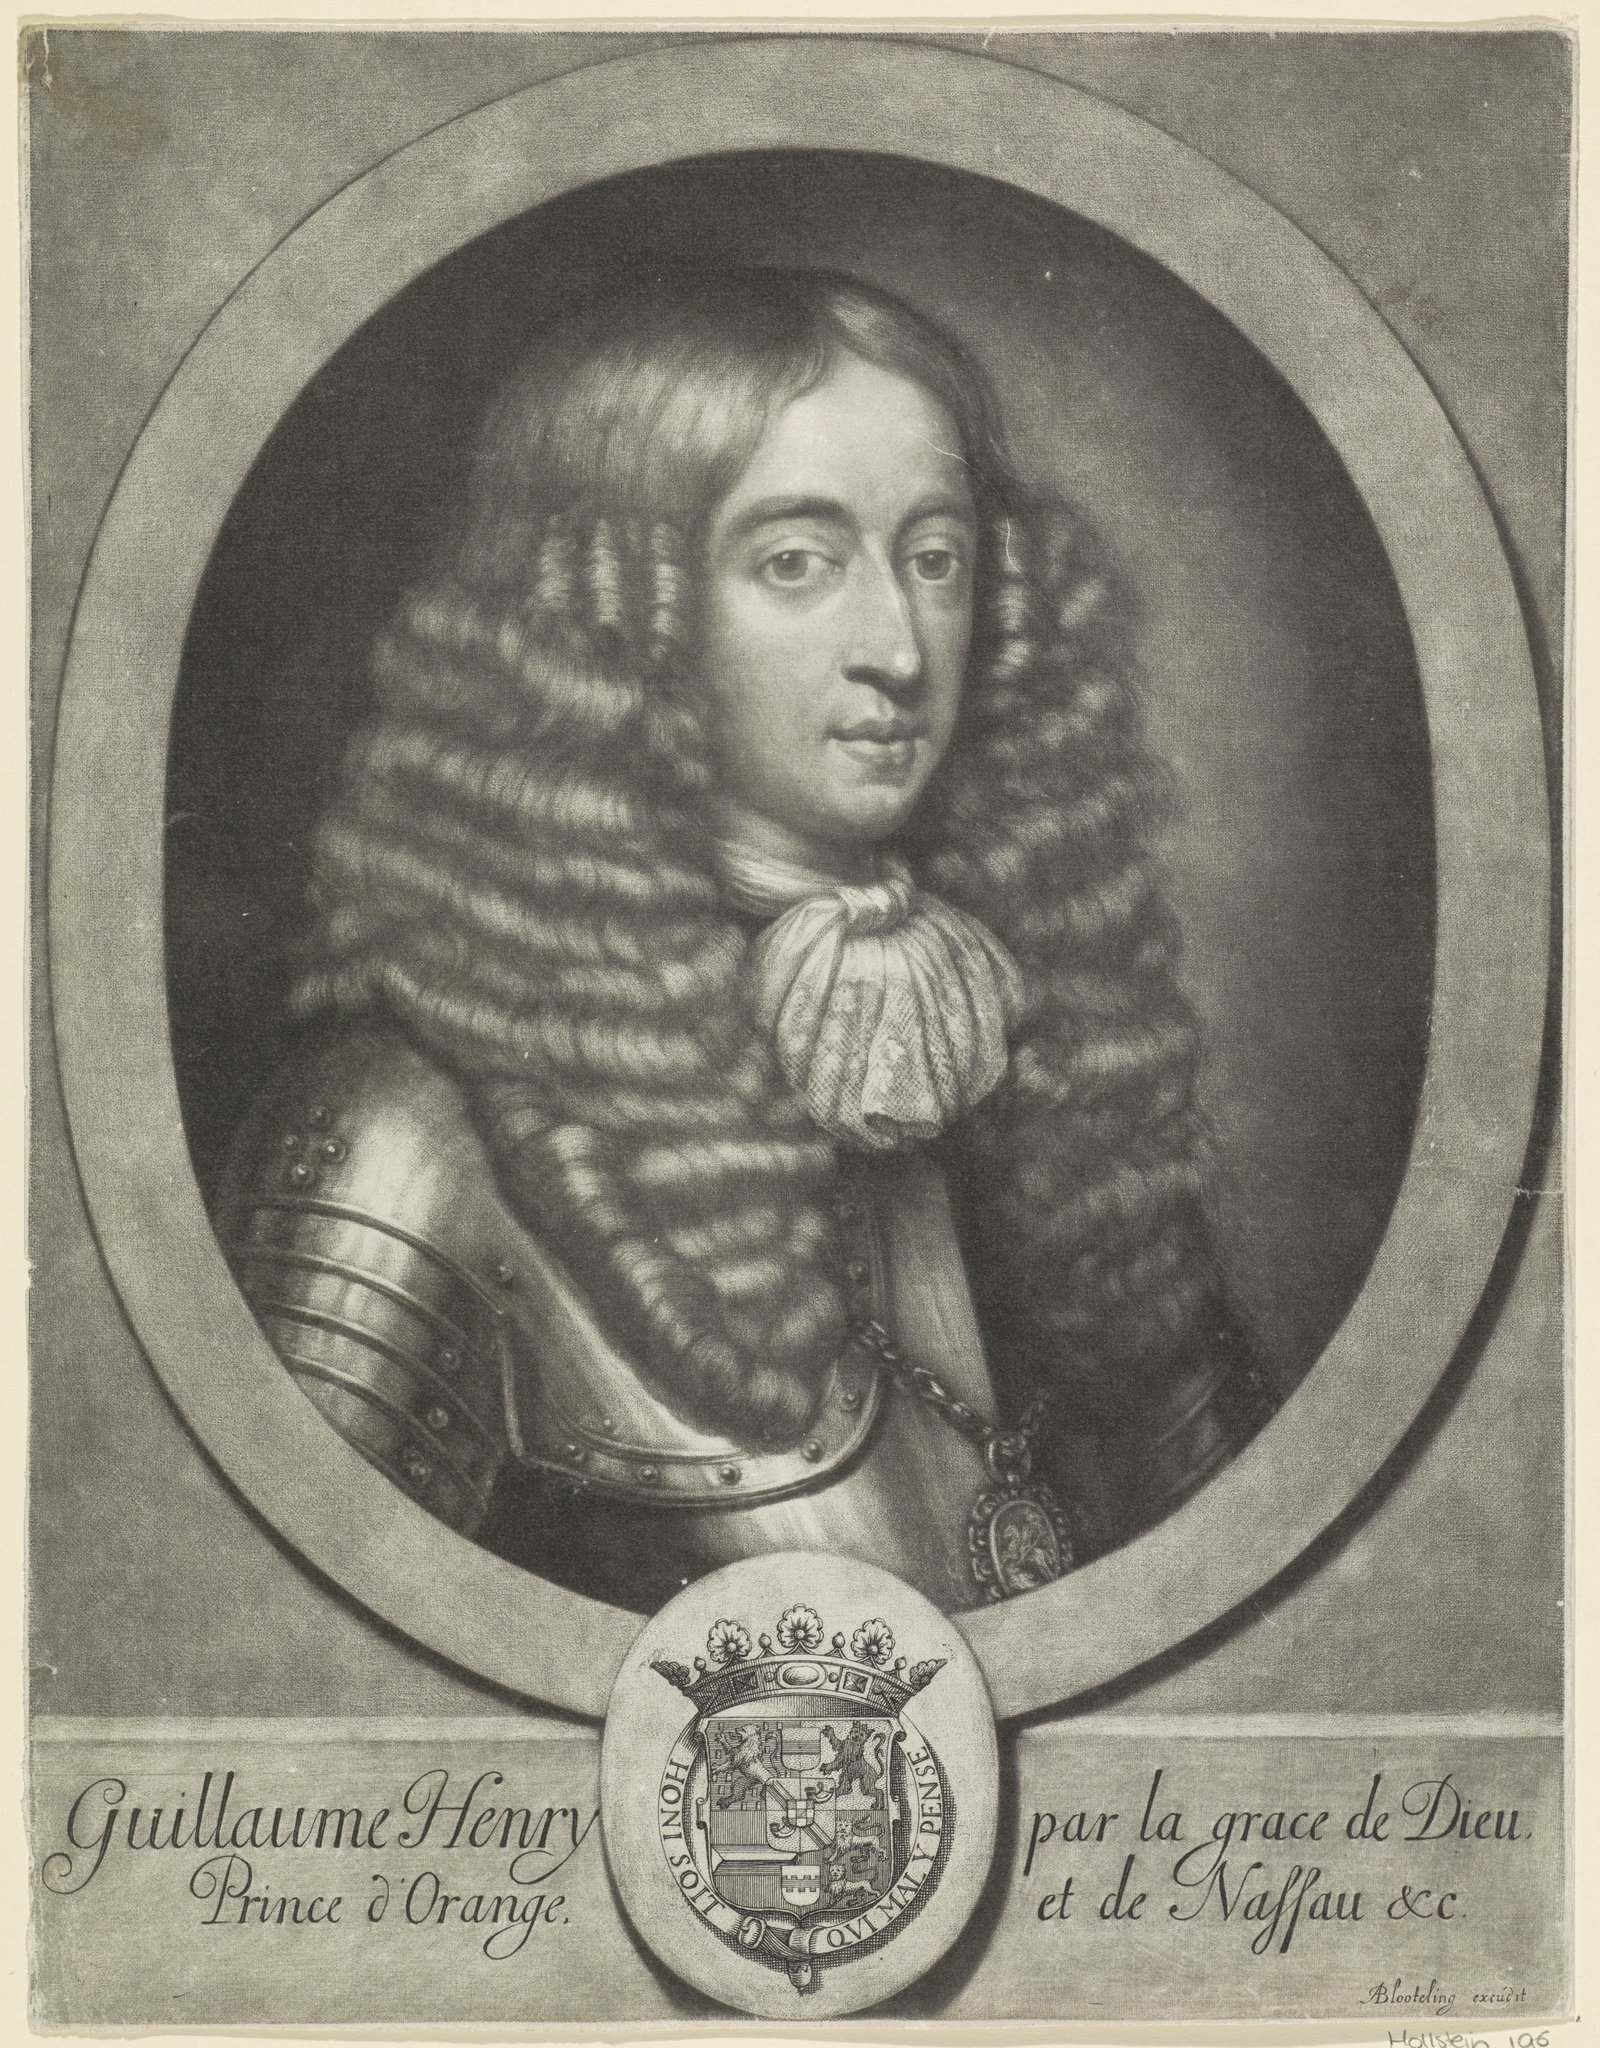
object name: print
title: Portret van Willem III, prins van Oranje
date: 1670-1690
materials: paper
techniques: mezzotint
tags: the hague, william iii (prince of orange and king of england, scotland, and ireland), knighthood order (garter) - insignia of a knighthood order, e.g.: badge, chain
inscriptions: collector's mark: Lugt 2228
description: Portret van Willem III in een ovaal. Midden onder zijn wapen met een kroon, gedecoreerd met de Kousenband en het devies van de Orde van de Kousenband. In de ondermarge zijn naam en titels.